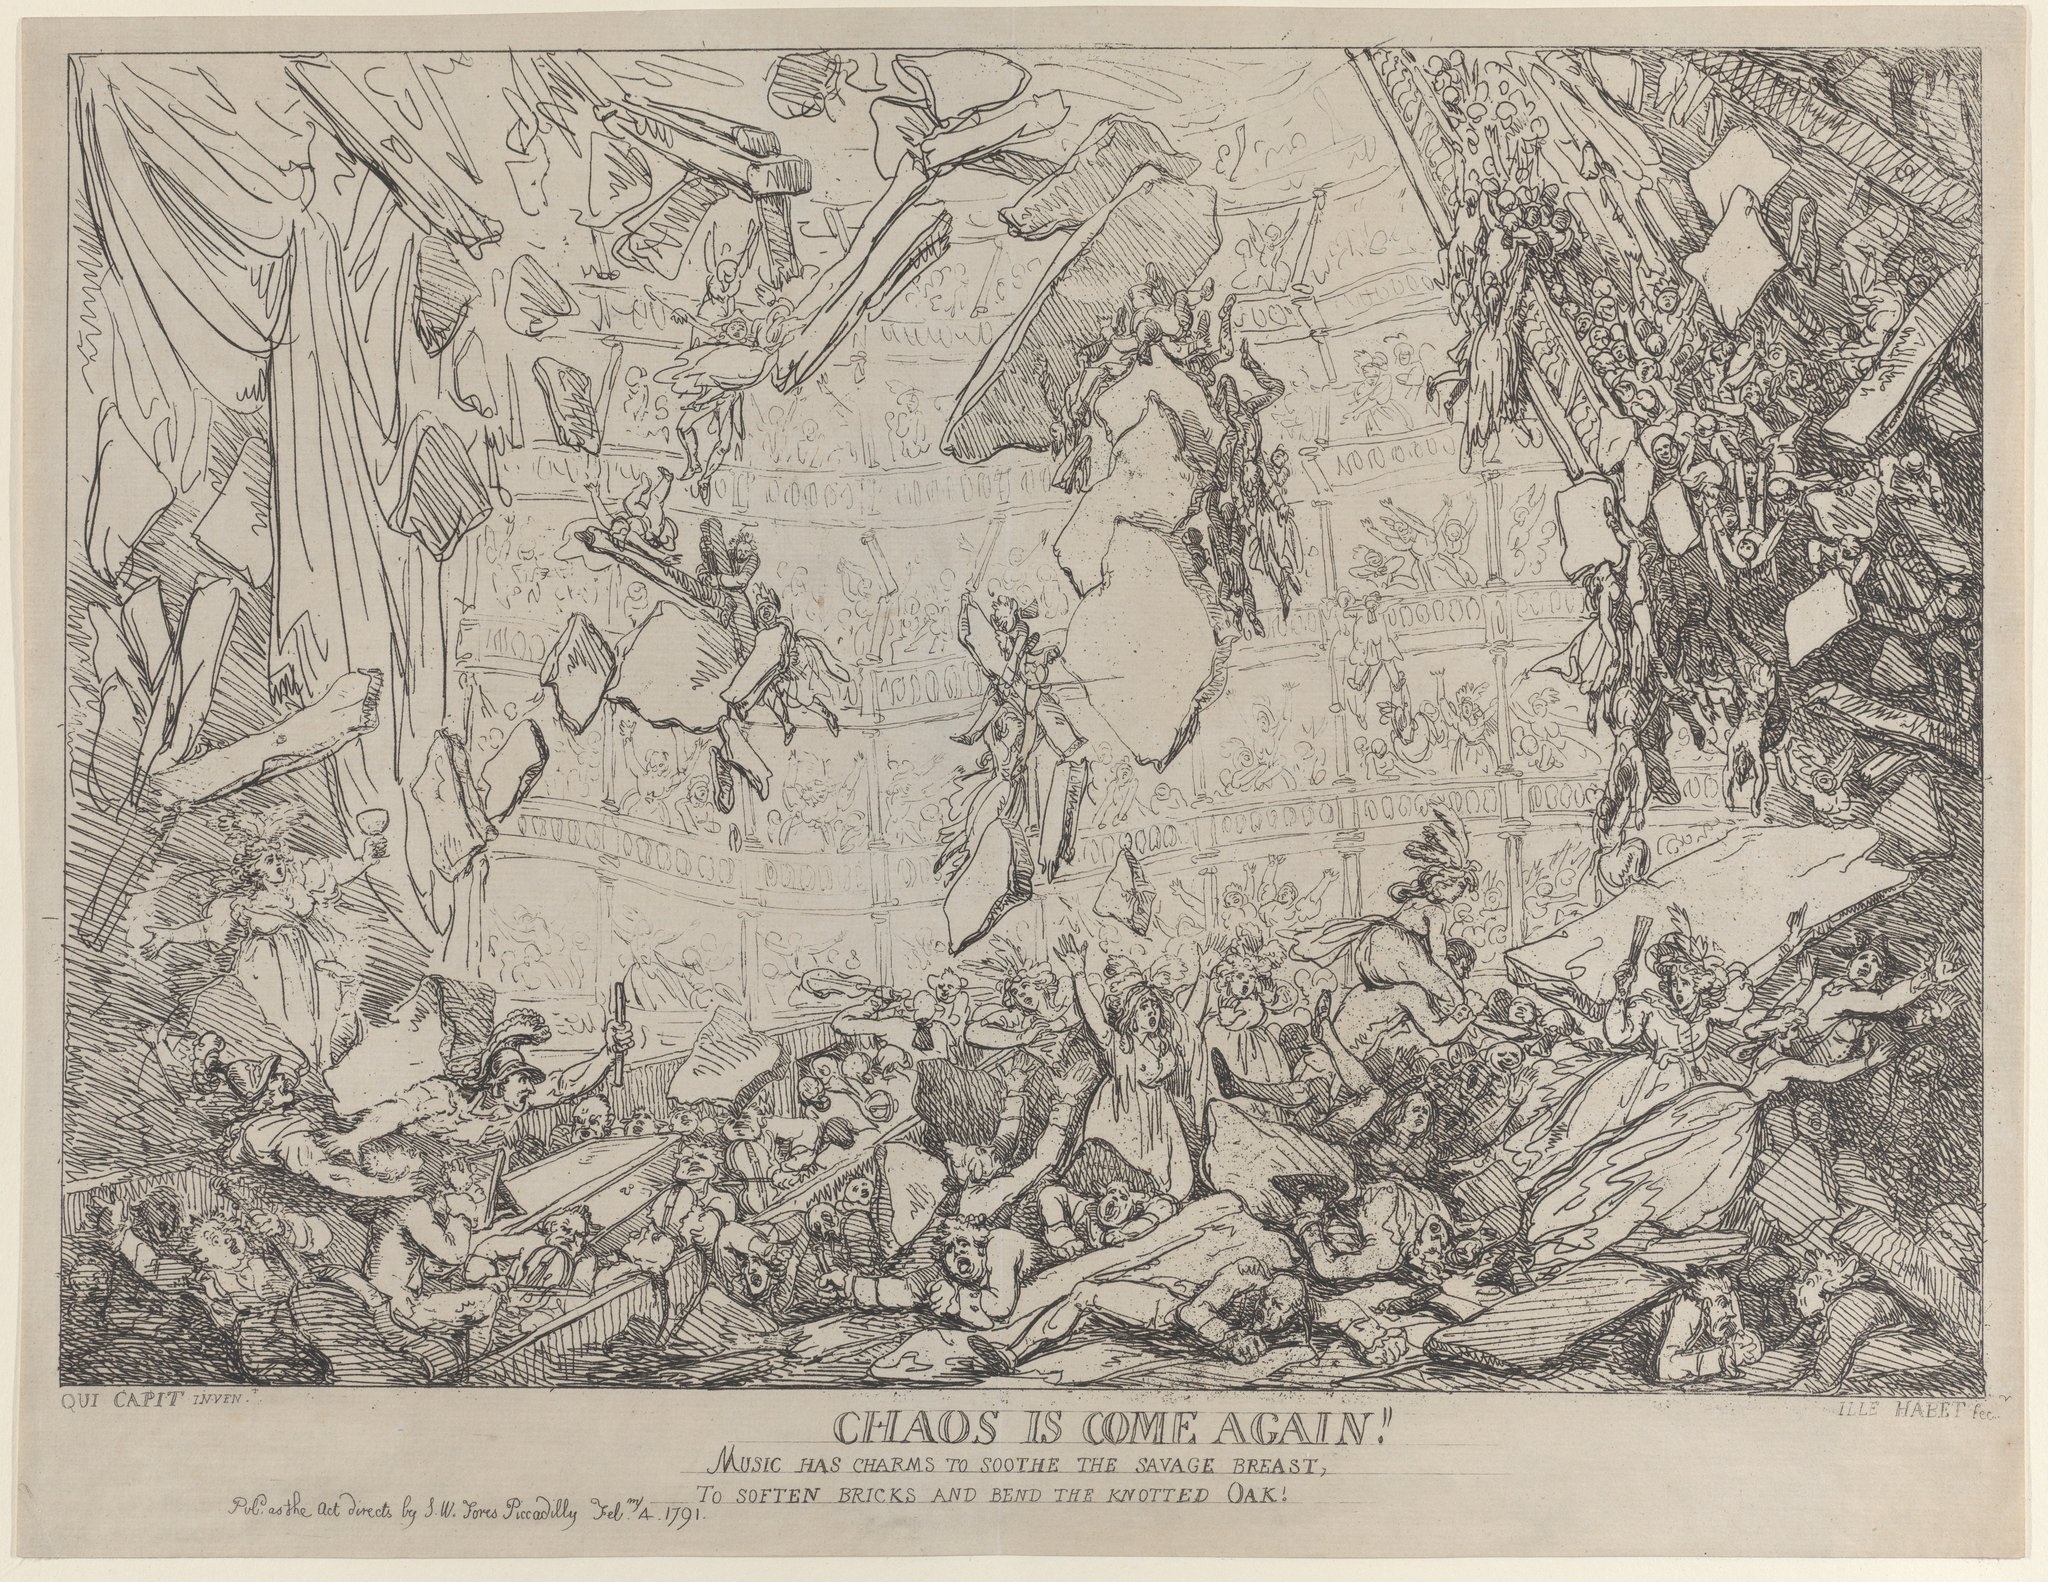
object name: print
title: Chaos is Come Again!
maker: thomas rowlandson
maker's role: artist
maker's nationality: british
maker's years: 1757-1827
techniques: etching